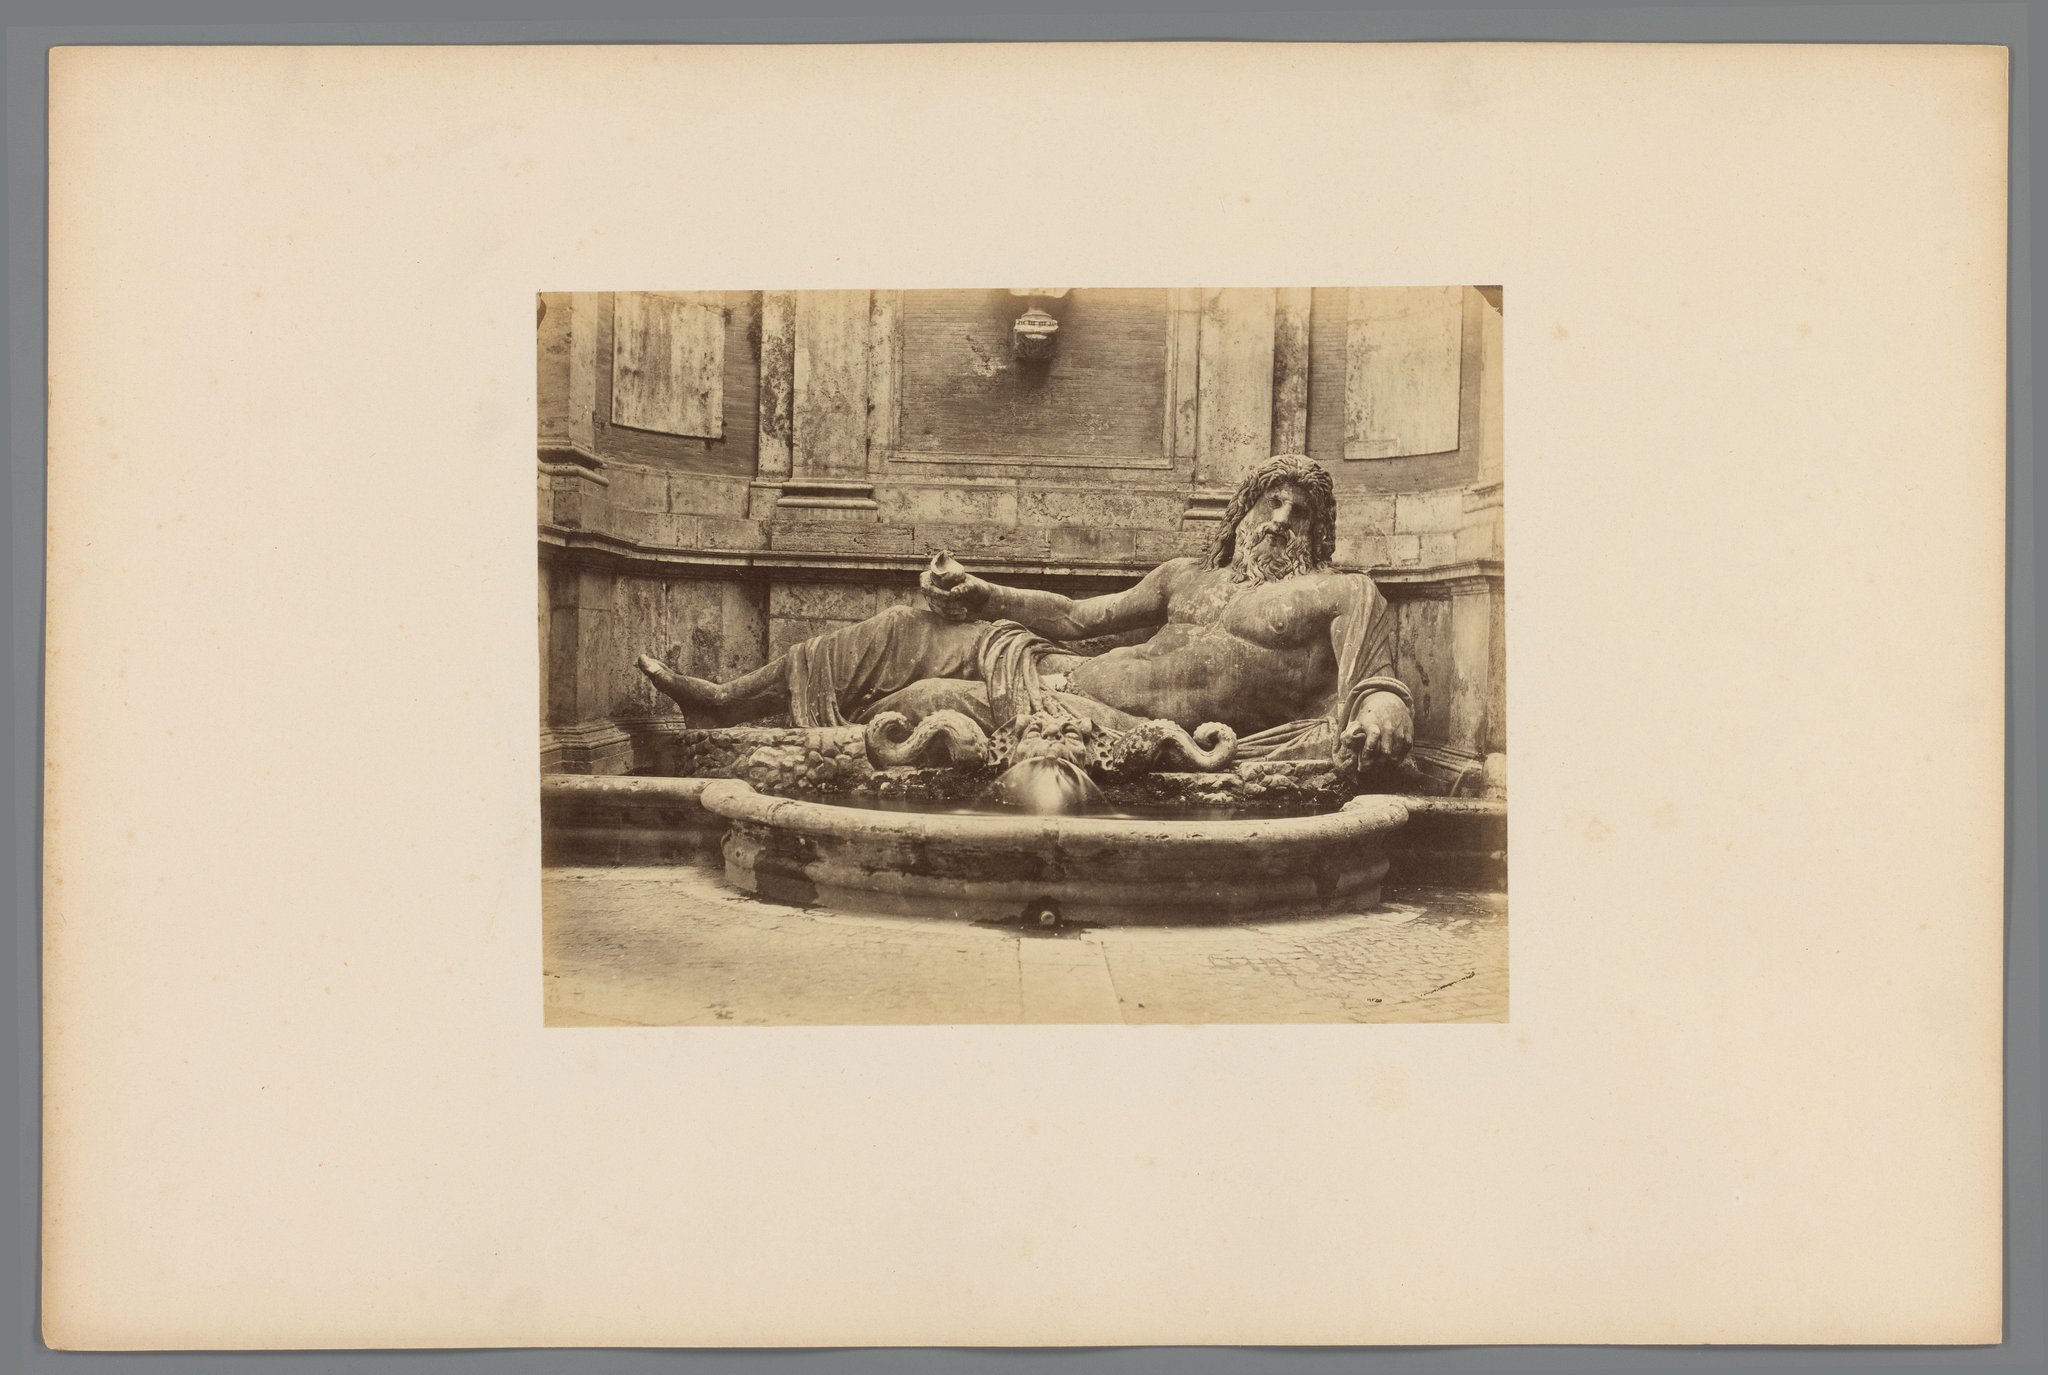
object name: photograph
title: Fontein van Marforio in het Palazzo Nuovo te Rome, Italië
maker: Anonymous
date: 1851-1900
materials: cardboard, paper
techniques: albumen print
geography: rome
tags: gods of the waters: the older dynasty (second series): children of oceanus, river and small water deities, ornamental fountain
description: De fontein van Marforio is een van de zes sprekende standbeelden van Rome waar de inwoners van de stad vanaf de zestiende eeuw hun politieke commentaar konden uiten door middel van plakkaten.